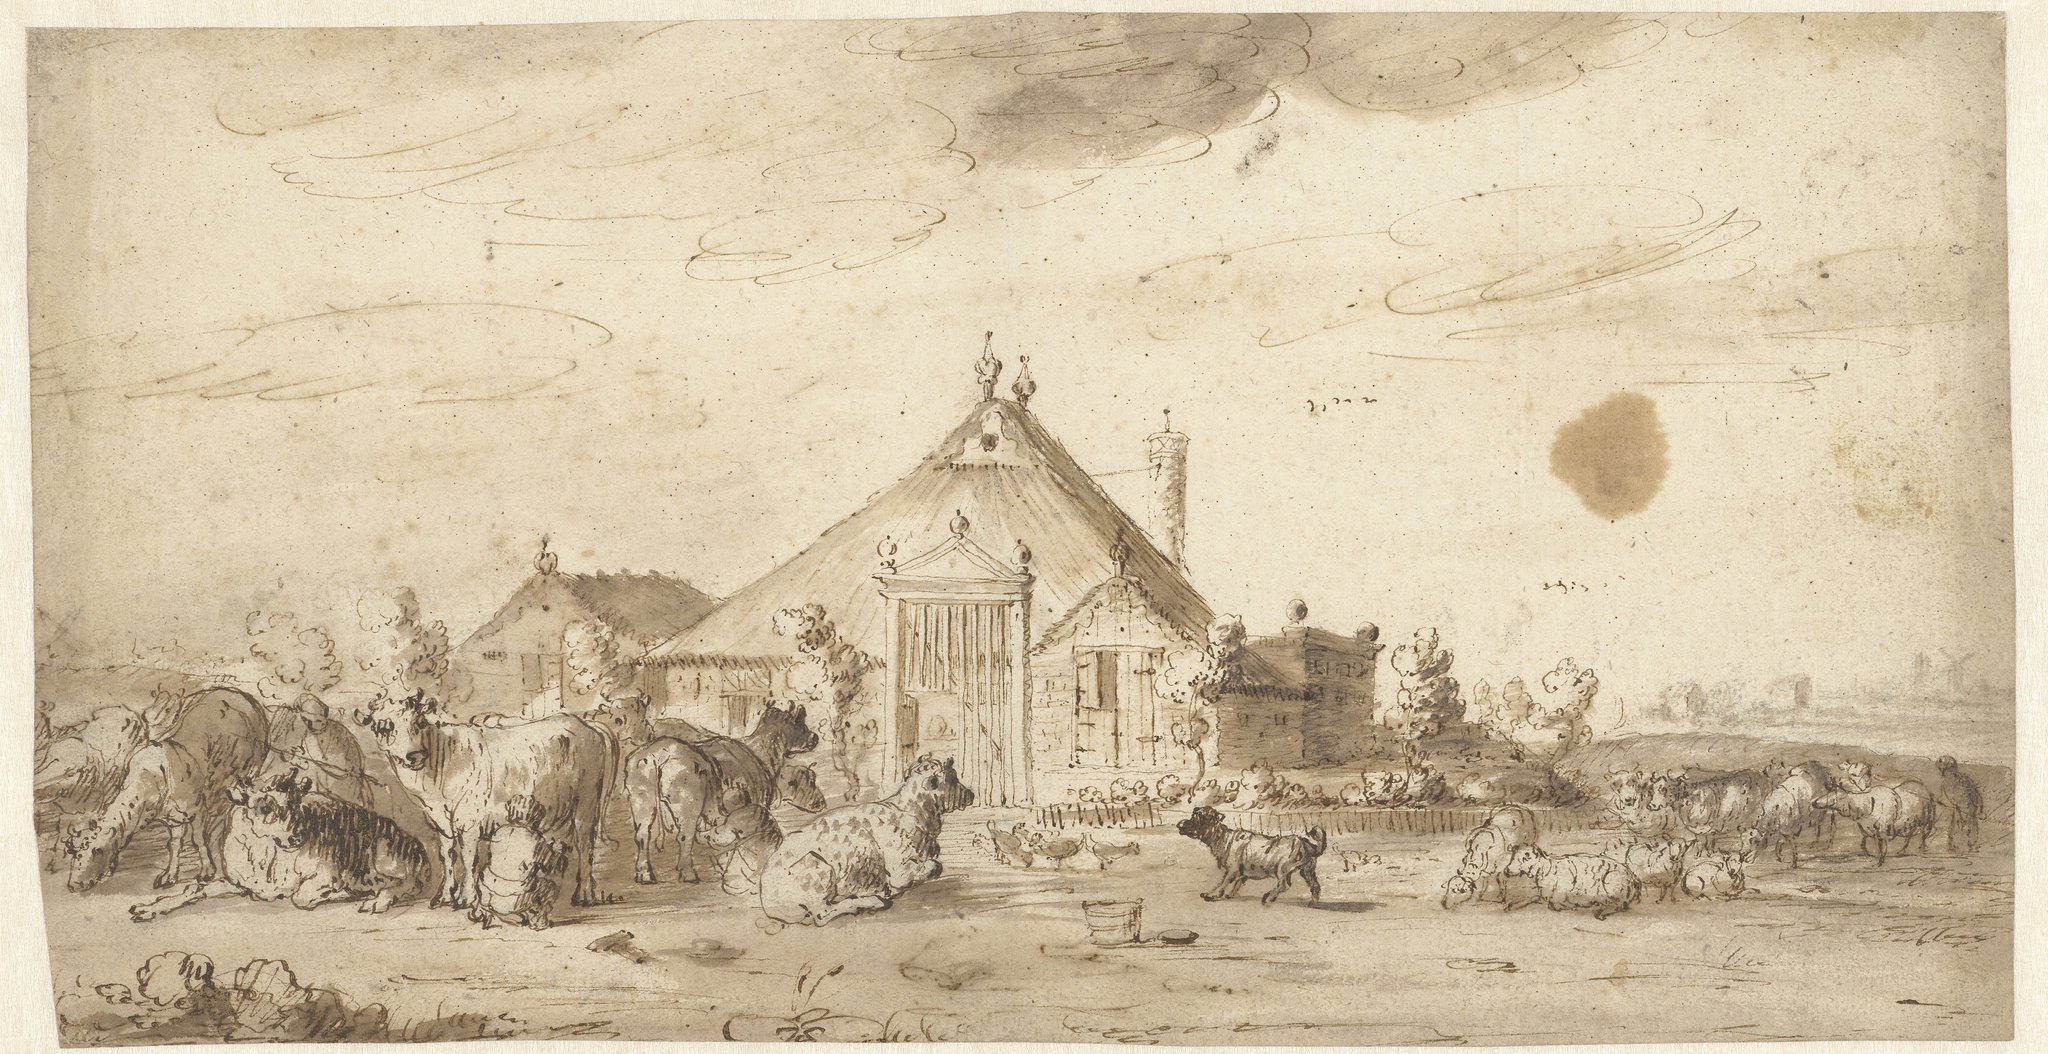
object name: drawing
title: Landschap met boerderij en vee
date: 1610-1705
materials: ink, paper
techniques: brush, pen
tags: cattle, farm (building)